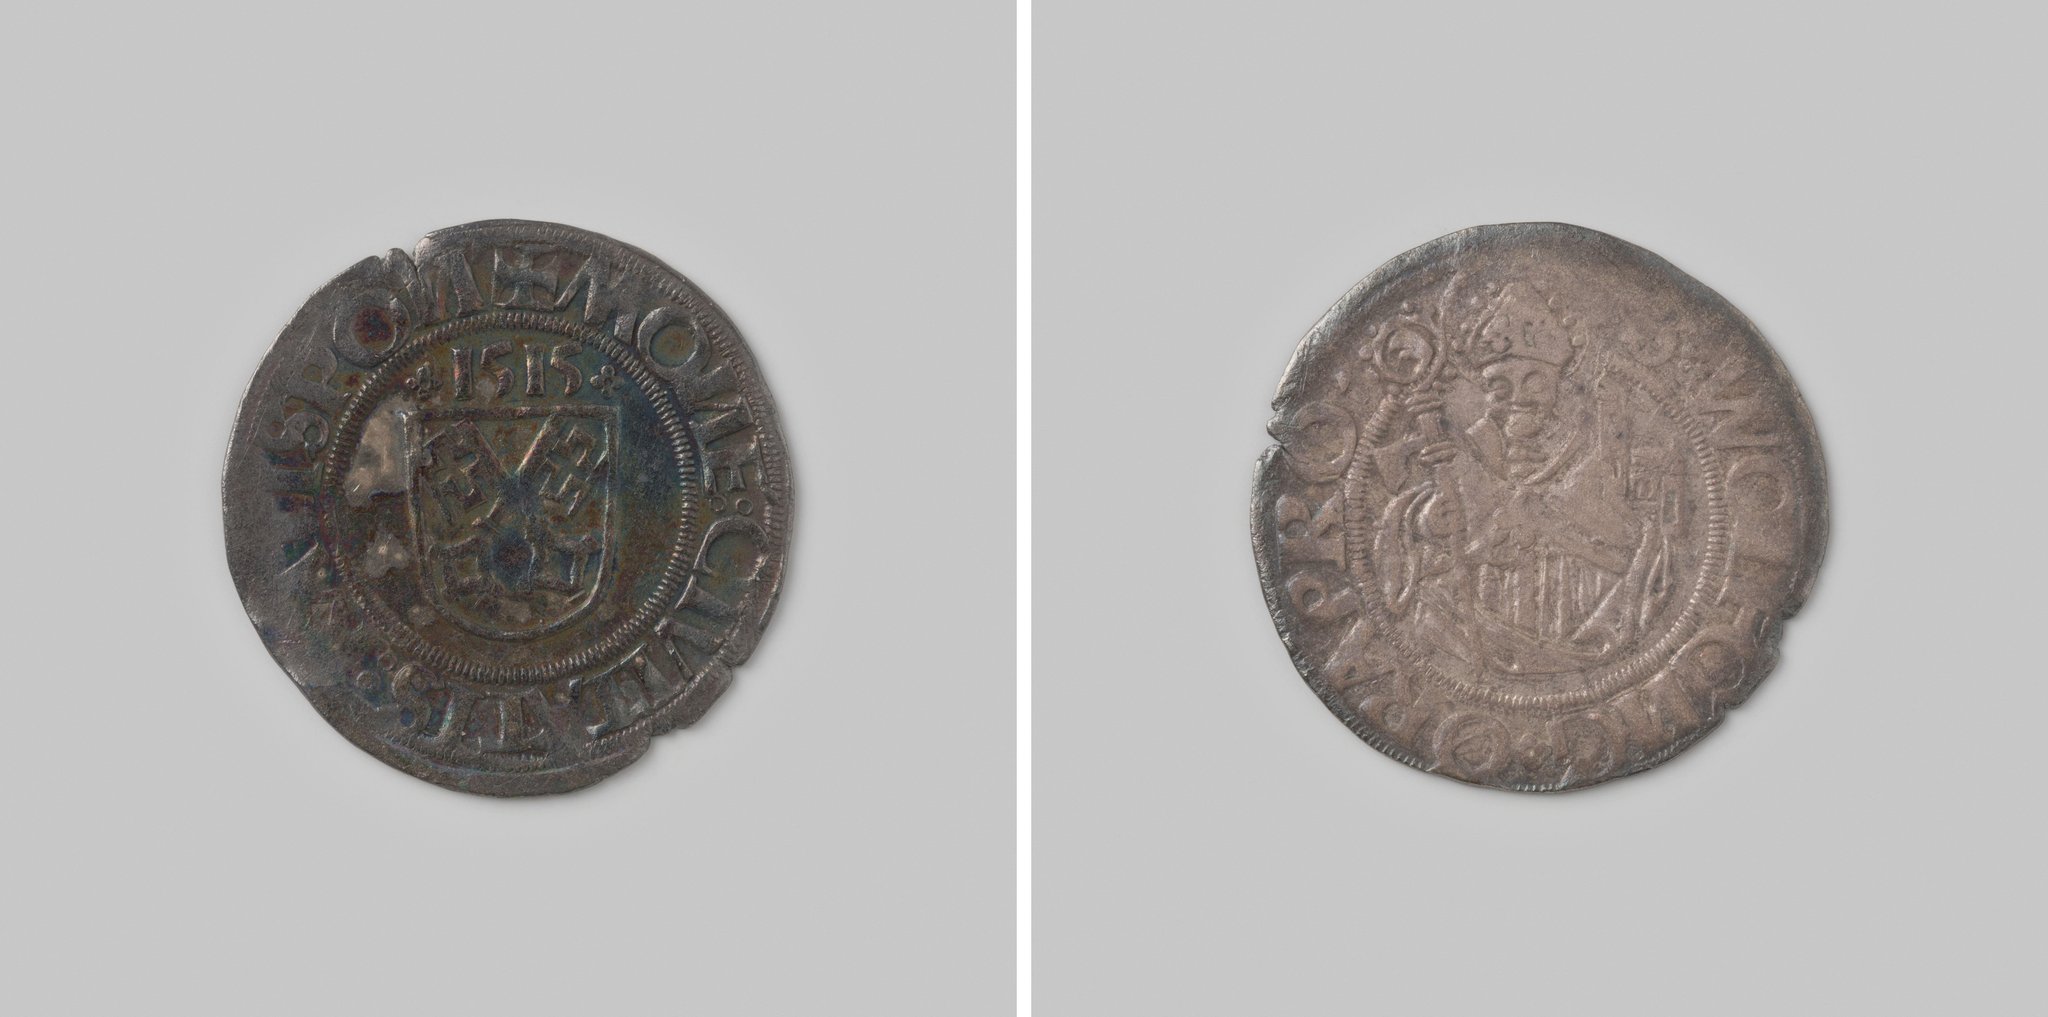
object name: coin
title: Rijksstad Regensburg, groschen, 1515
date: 1515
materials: silver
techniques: striking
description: Zilveren munt. Voorzijde: wapenschild van de stad, waarboven jaartal. Keerzijde: heilige met staf in rechterhand, op de achtergrond een kerkgebouw.